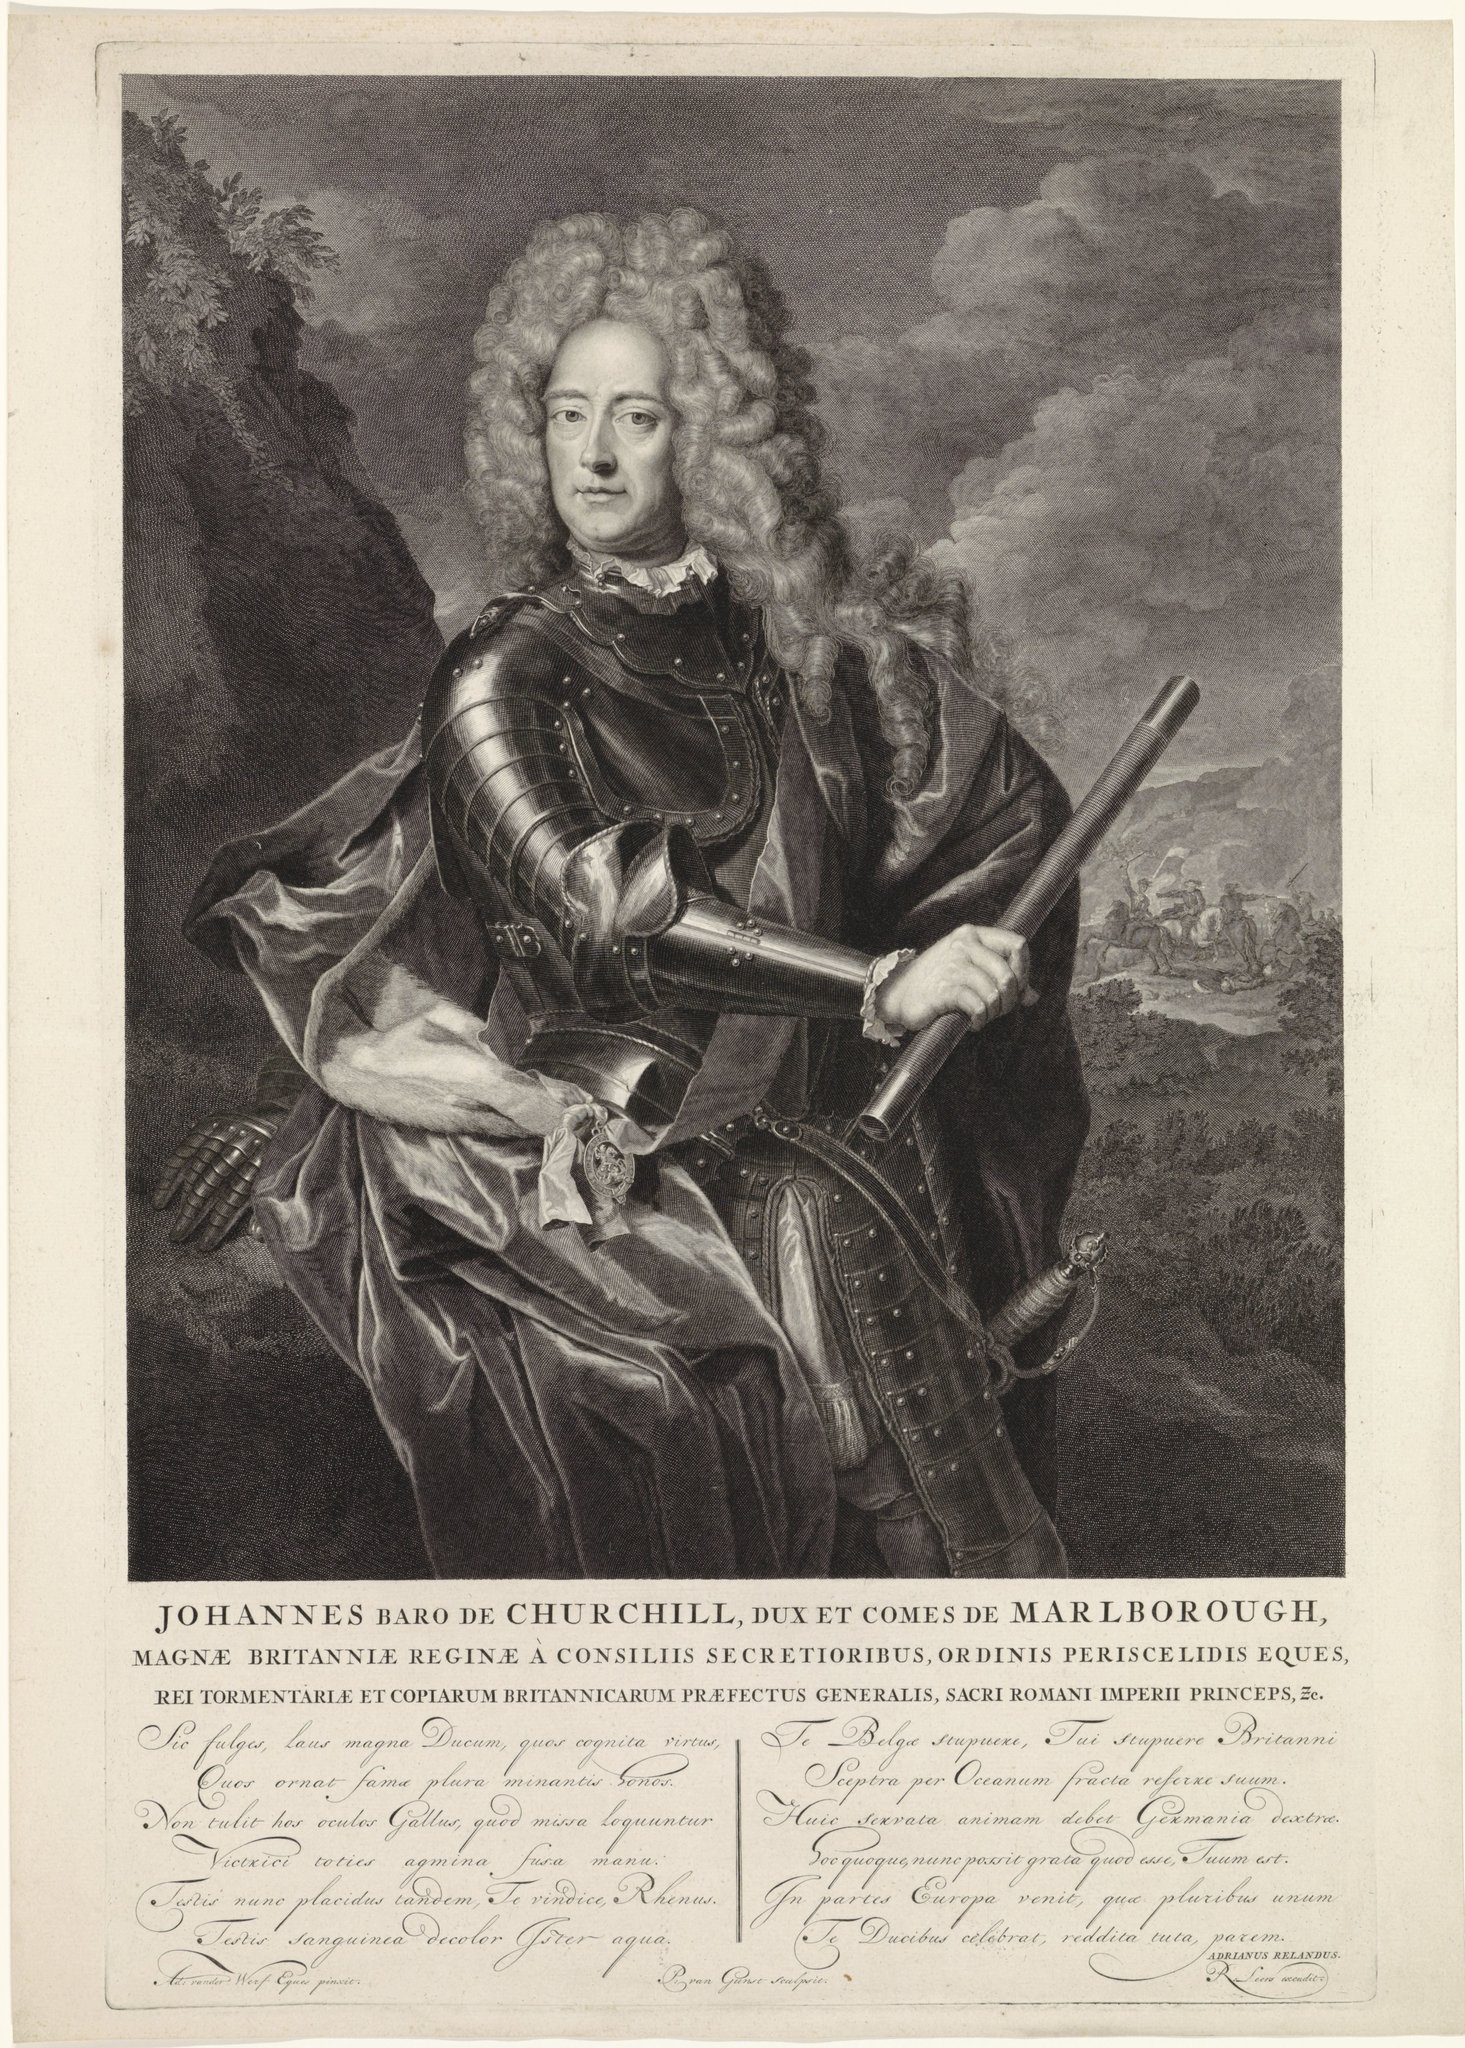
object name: print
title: Portret van John Churchill, hertog van van Marlborough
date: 1701-1731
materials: paper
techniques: engraving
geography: amsterdam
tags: john churchill (1e hertog van marlborough), battle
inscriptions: collector's mark: Lugt 2228, inscription: ‘Het Lat. onderschrift ingeslepen’, inscription: ‘Op de laatste staat leest men in de marge er 3 regels onderschrift. Jean, baron de Churchill, duc et comte de Marlborough. Jean, baron de Churchill, duc et comte de Marlborough, conseiller interne de la reyne d'angleterre chevalier de Londen de la jaretiene, commendant general de lártillerie des troups angloises prince de 1 empie. In het miodden odner deze regels. A Paris ches Basset rue St Jacques.’, collector's mark: Lugt 240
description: John Churchill, hertog van van Marlborough en generaal van het Engelse leger tijdens de Spaanse successieoorlog. Op de achtergrond een veldslag. De prent heeft een Latijns onderschrift.